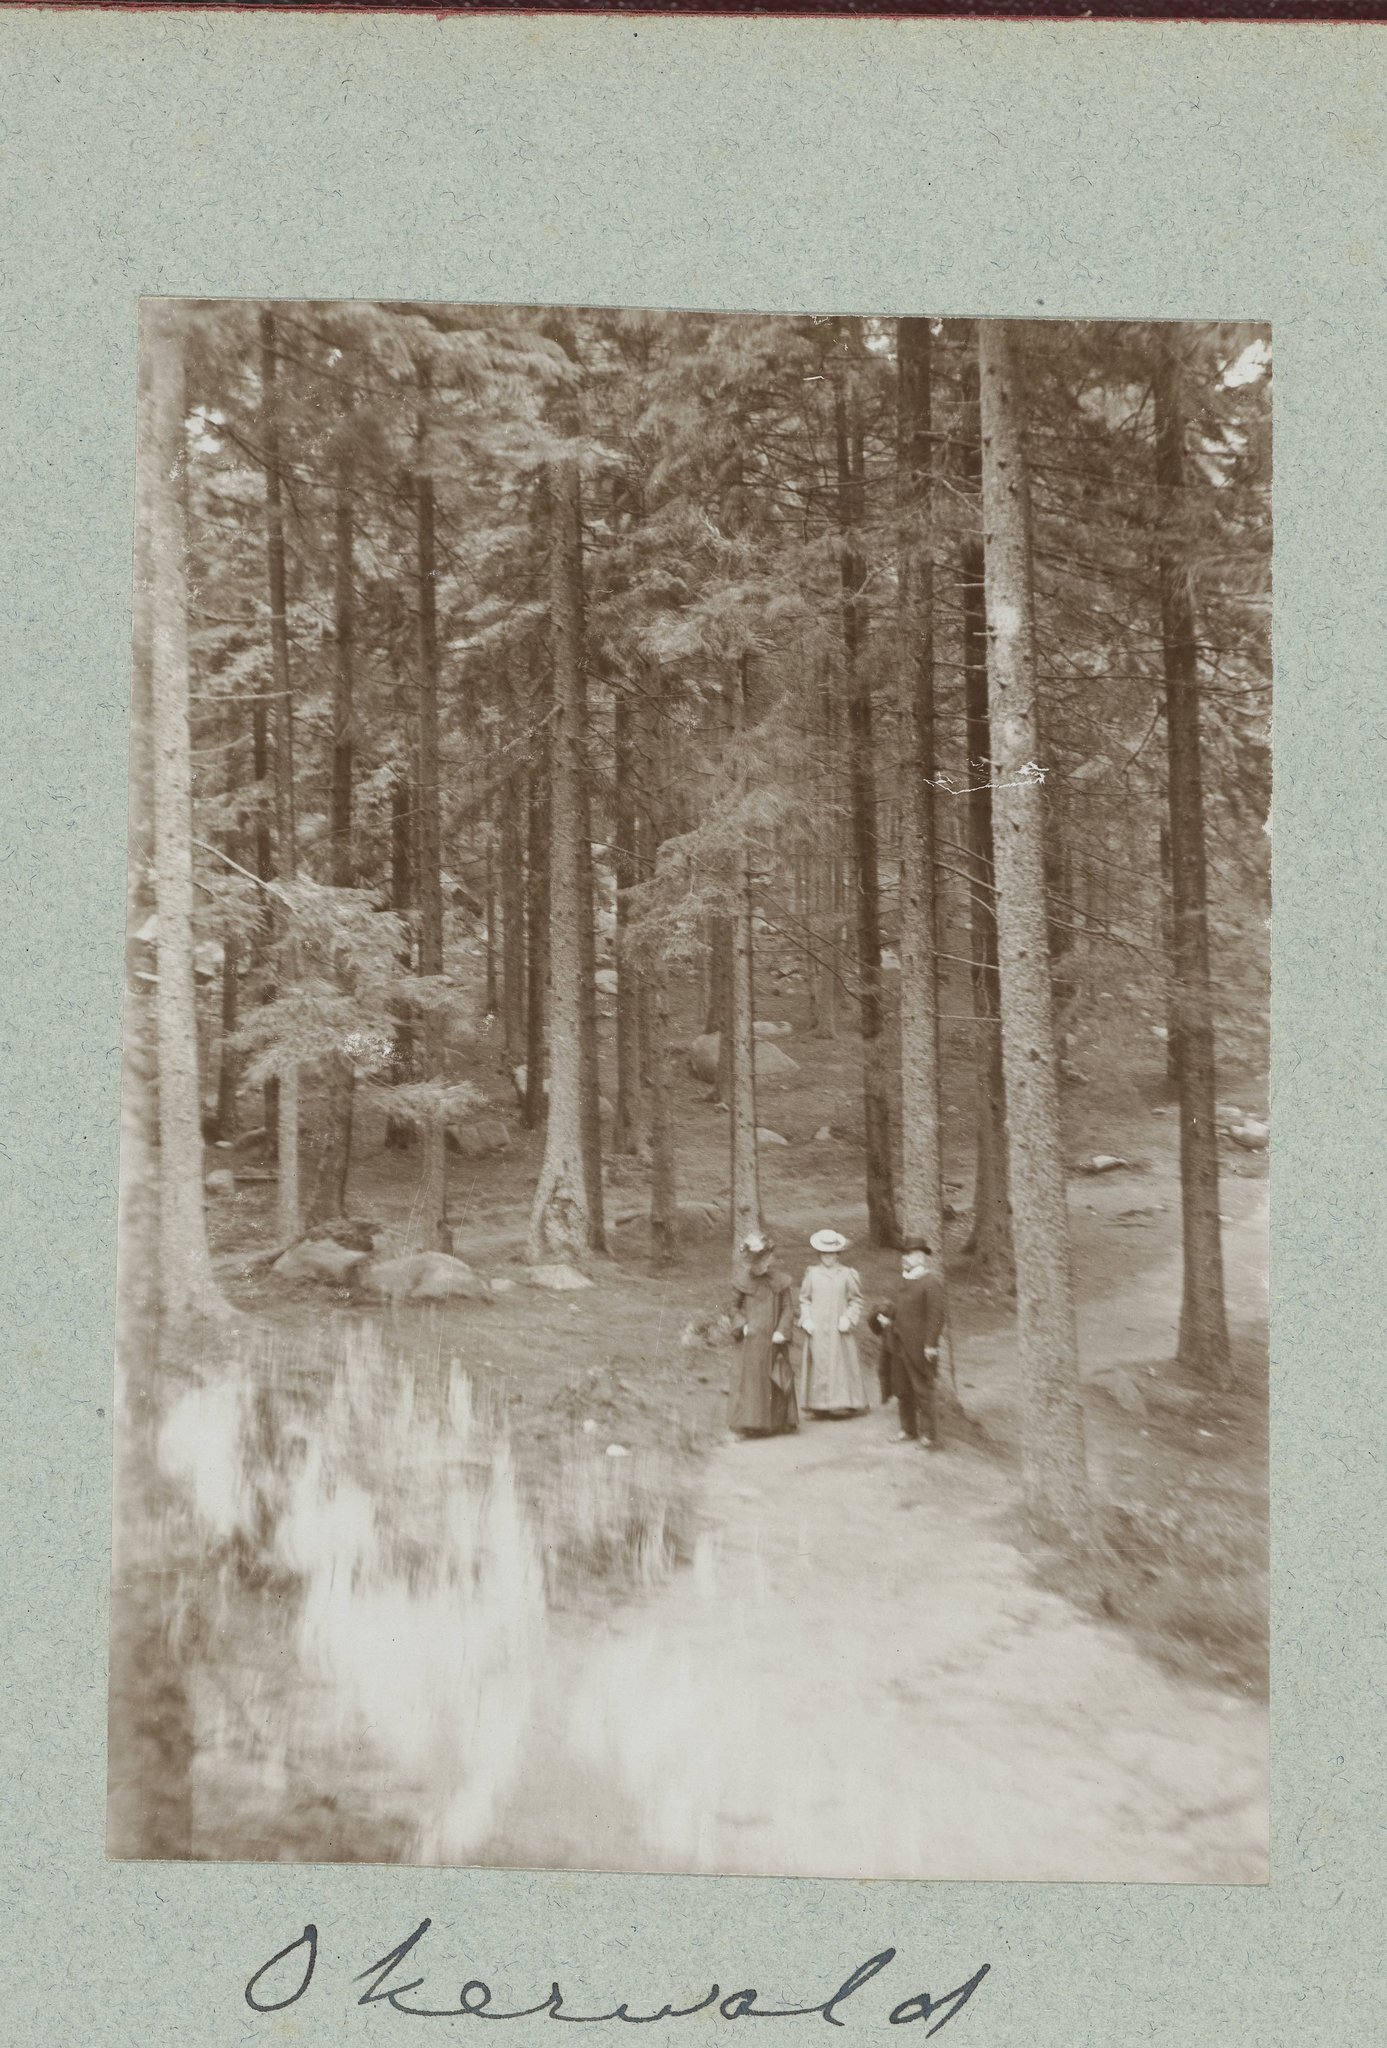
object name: photograph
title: Okerwald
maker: frits freerks fontein fz.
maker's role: fotograaf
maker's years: 1882-1928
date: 1903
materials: cardboard, paper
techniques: gelatin silver print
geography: germany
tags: dutch east indies, the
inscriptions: caption: ‘Okerwald’